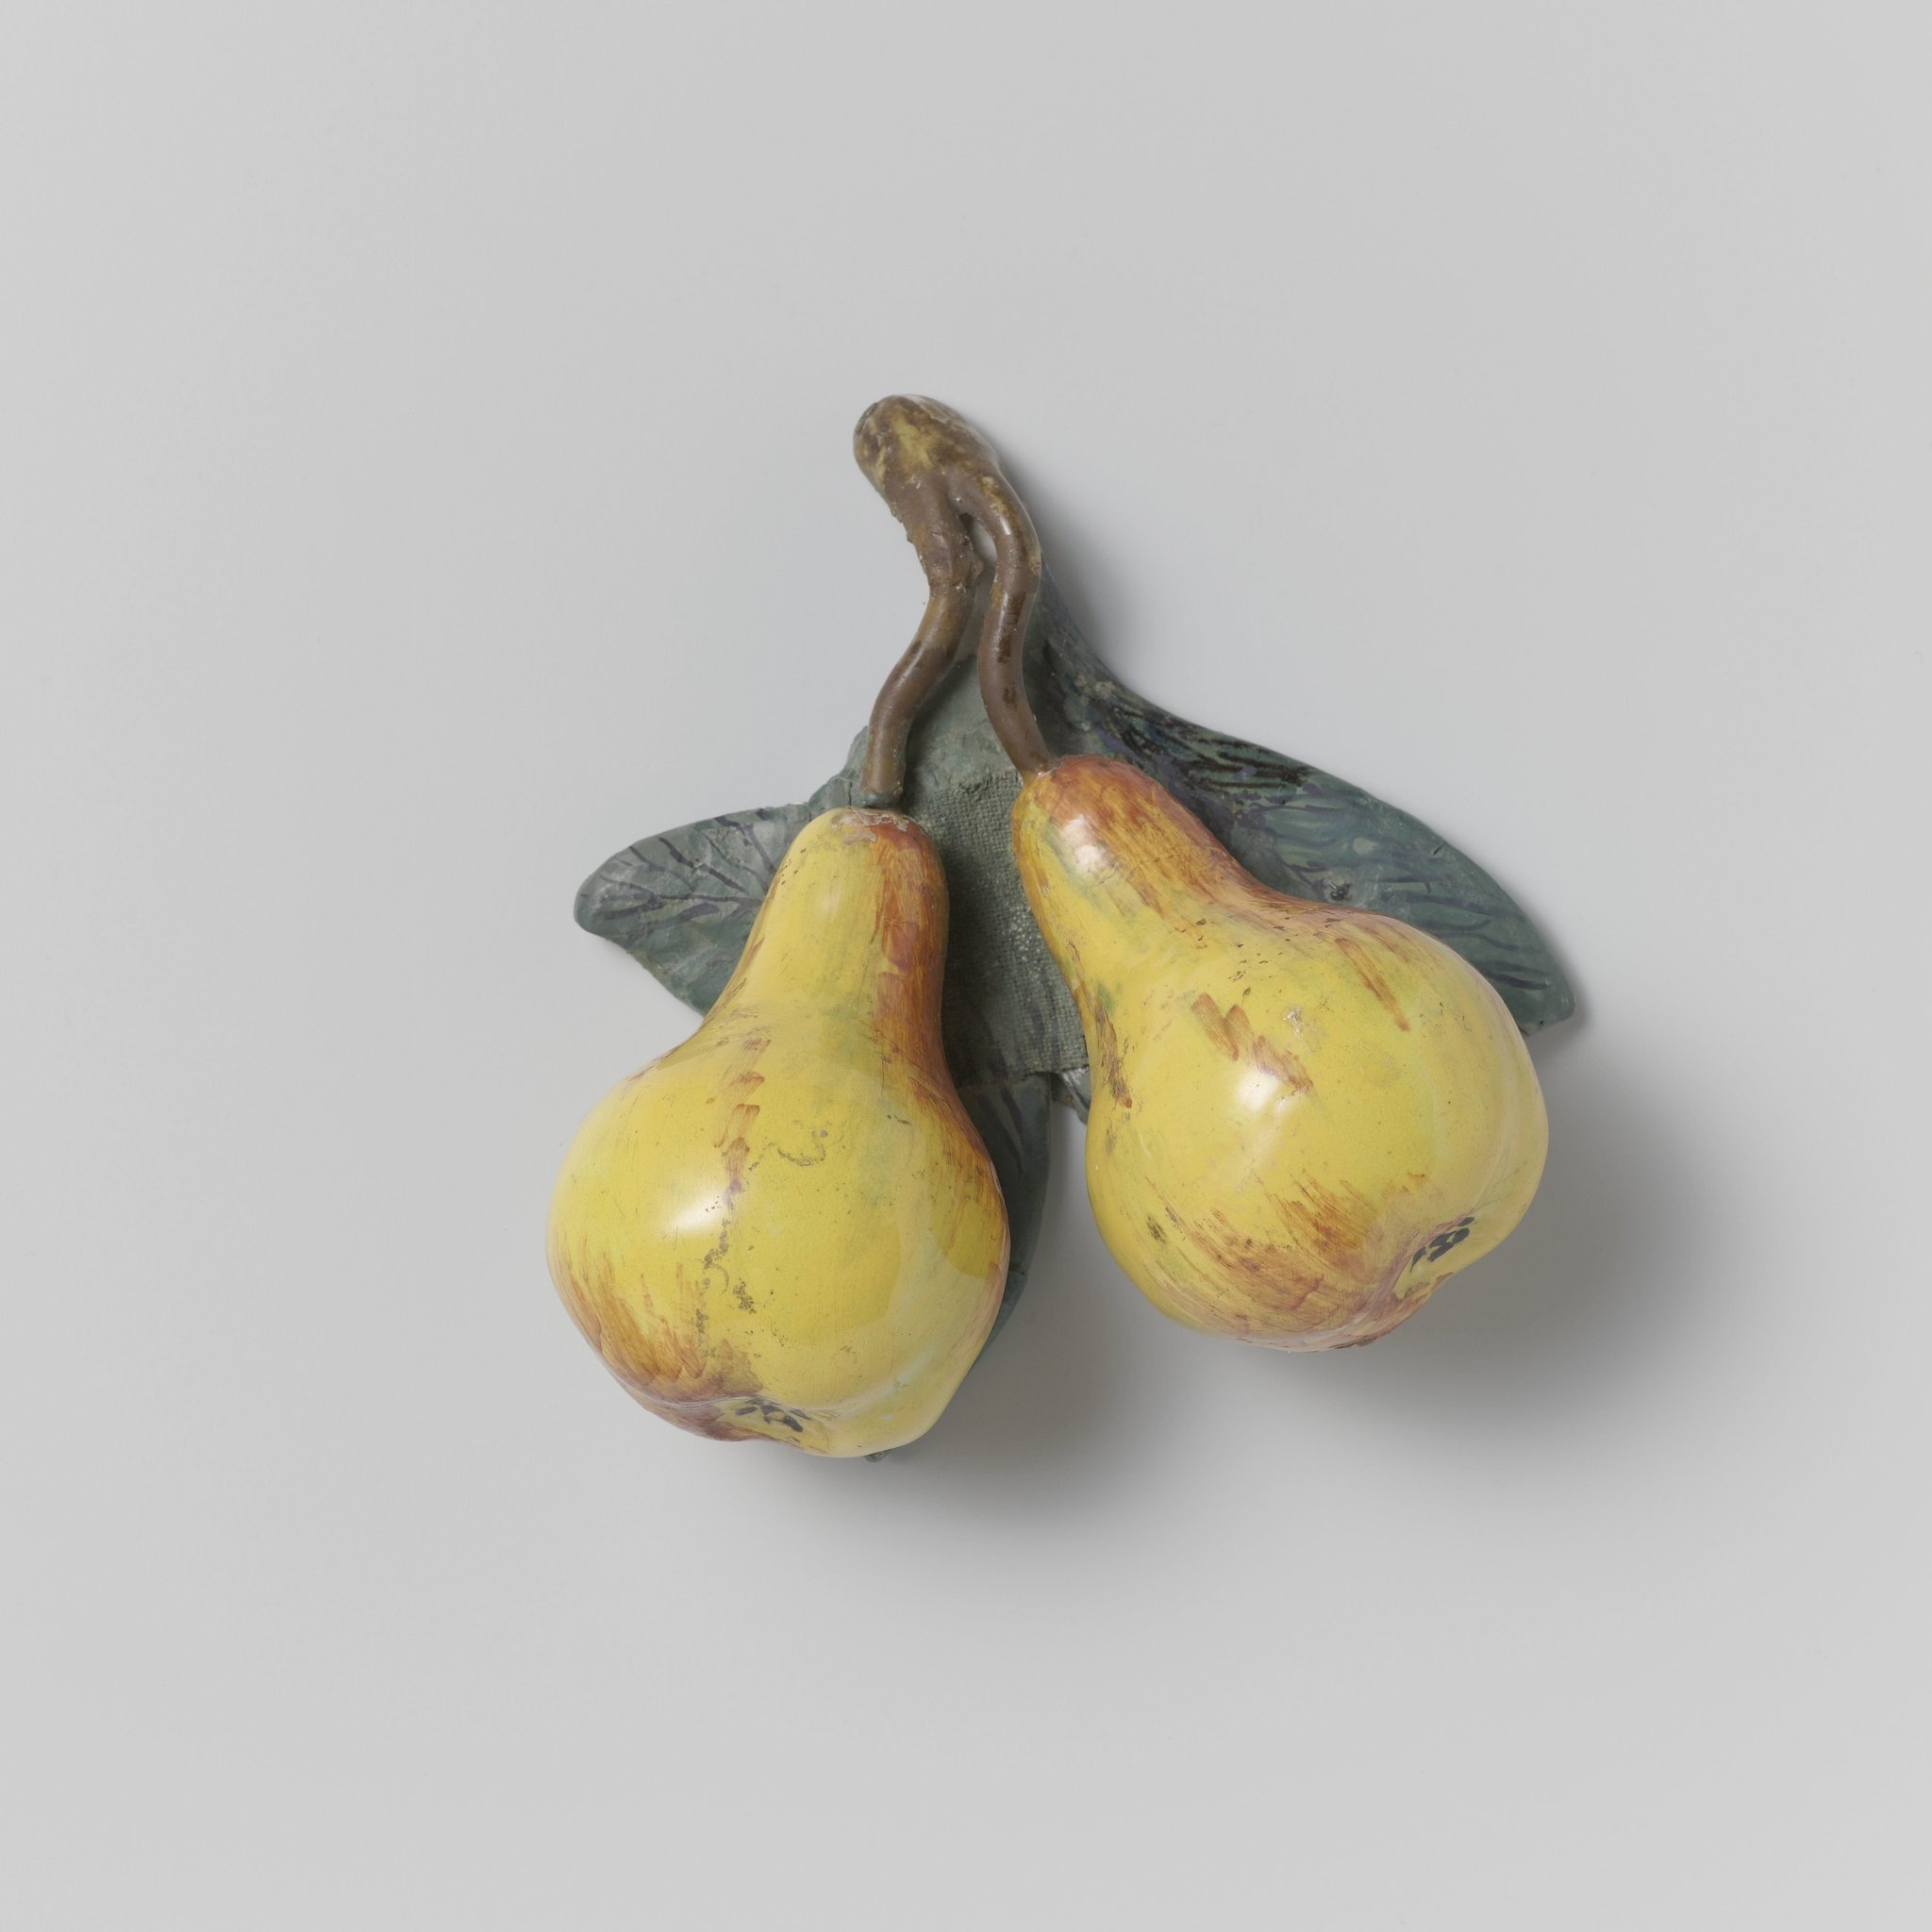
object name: artificial fruit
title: Two pears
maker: Anonymous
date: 1750-1775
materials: earthenware, glaze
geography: delft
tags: fruits: pear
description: Kunstfruit van veelkleurig beschilderde faience, in de vorm van twee gele peren met oker accenten en drie donkergroene bladeren.